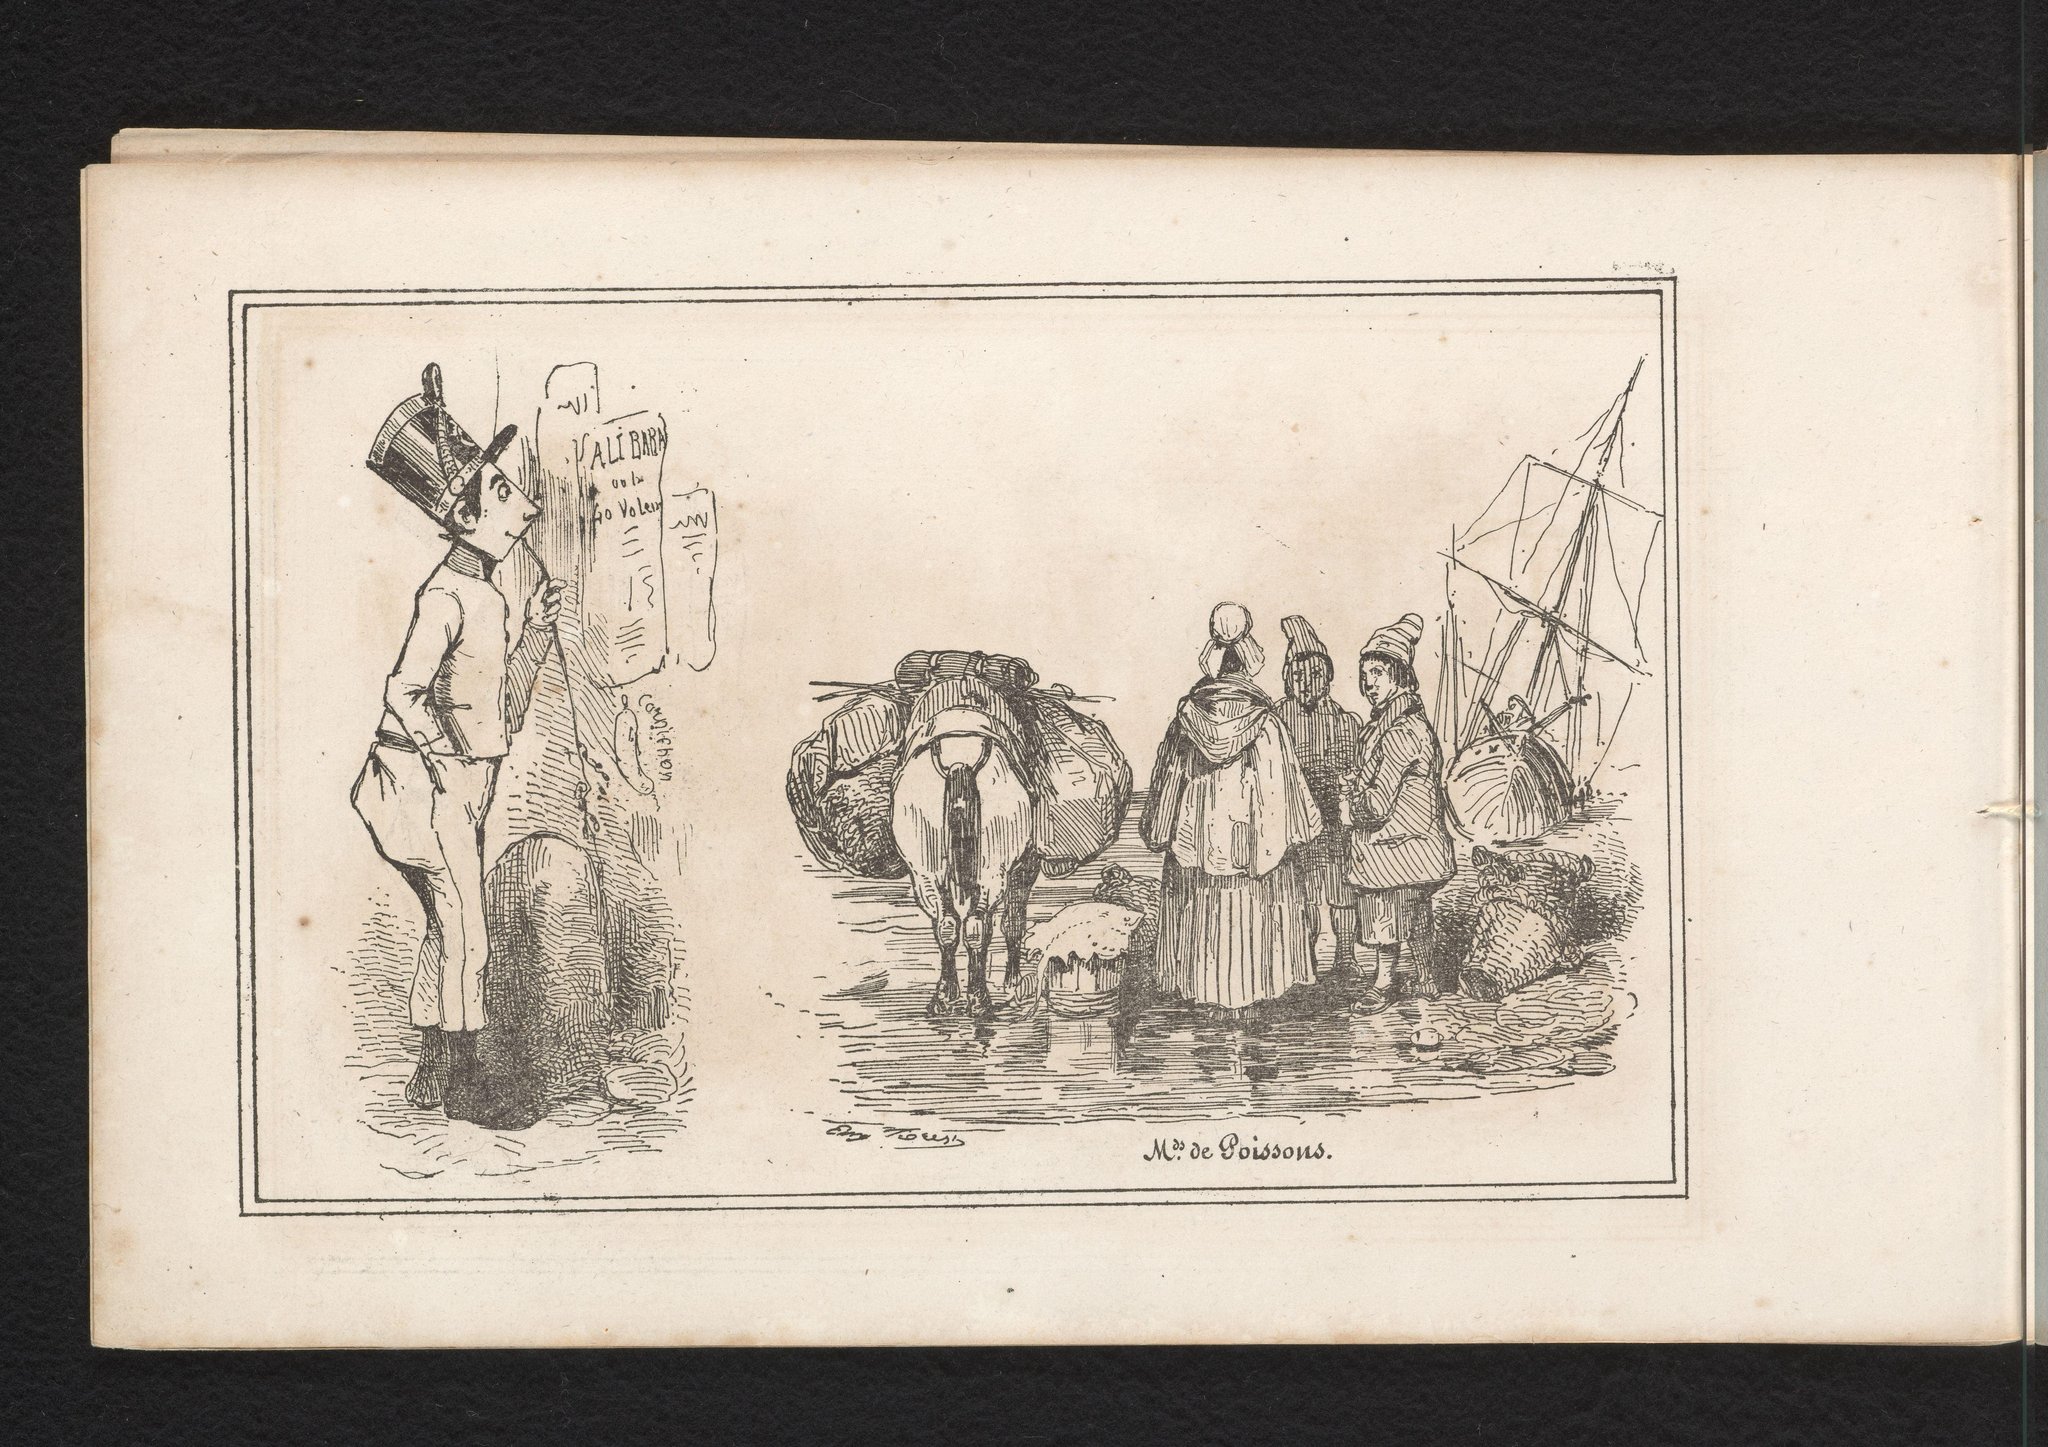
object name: print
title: Mds de Poissons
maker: eugène hippolyte forest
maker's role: print maker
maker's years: 1808-1866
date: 1834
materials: paper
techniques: engraving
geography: paris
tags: ass, donkey, poster-pillar, beach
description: Blad met twee afzonderlijke voorstellingen. Deze prent maakt deel uit van een album.